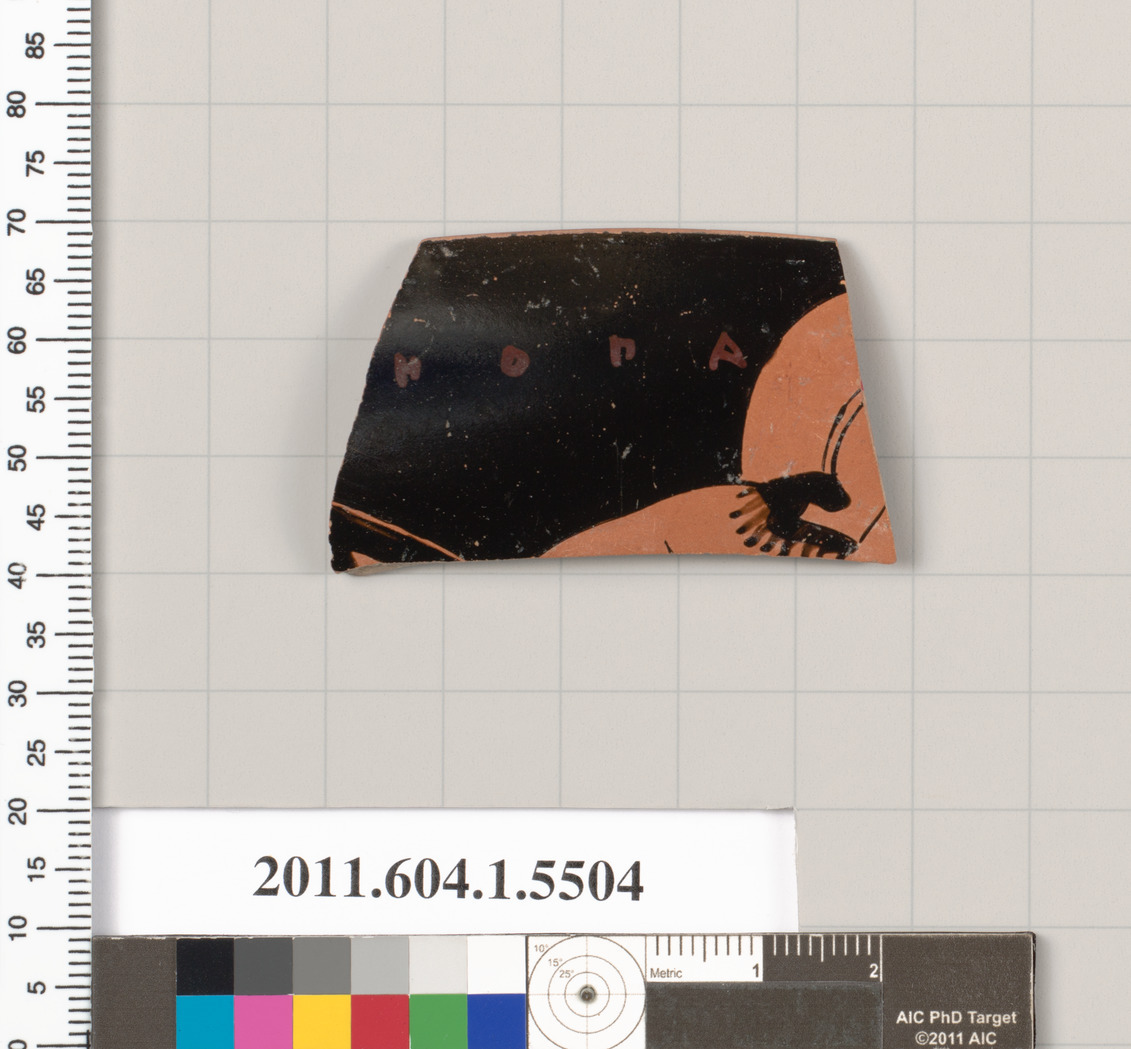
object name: kylix fragment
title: Terracotta rim fragment of a kylix (drinking cup)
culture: greek, attic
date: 520-510 BCE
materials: terracotta